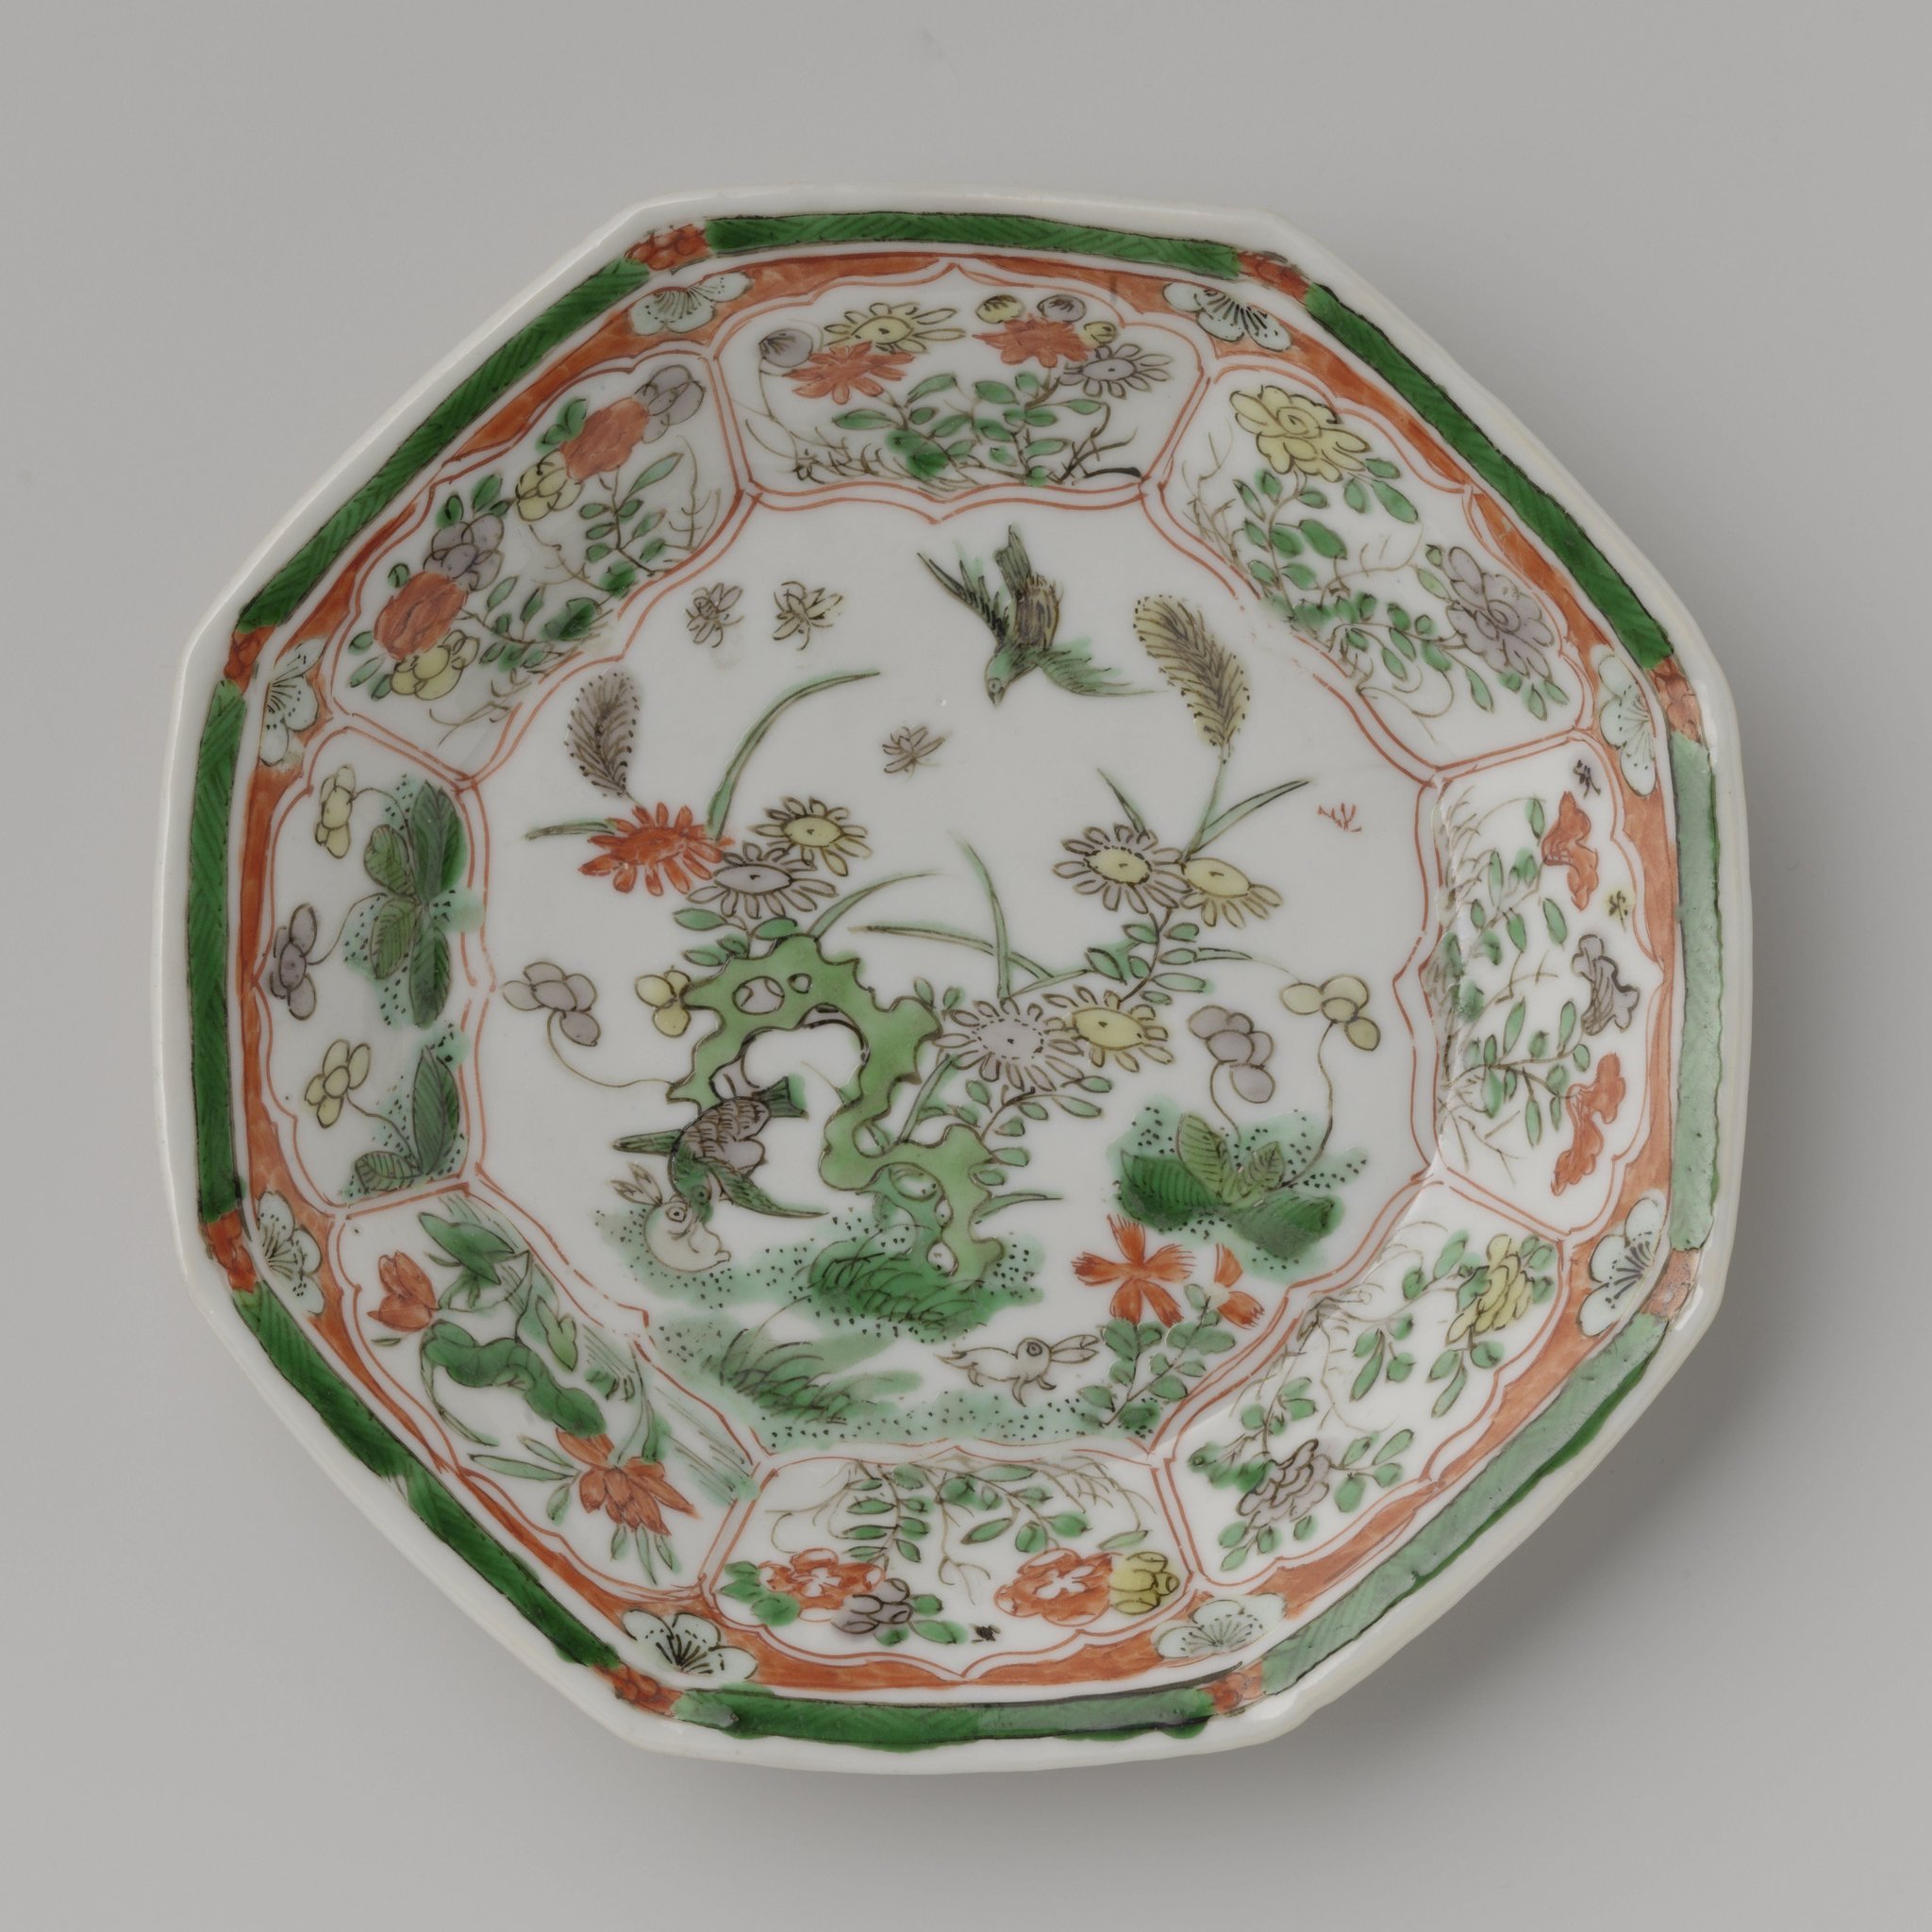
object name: platter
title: Octagonal saucer with light brown, animals and flower sprays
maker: Anonymous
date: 1700-1724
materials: cobalt, glaze, paint, porcelain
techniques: firing, forming, turning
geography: china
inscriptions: mark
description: Kop en schotel, achtkantig, cafe-au-lait, famille verte, met decors van bloeiende planten, haasjes en vogels. Op de buitenzijde zijn op een zeemleerkleurig fond bloempjes in afstekende kleuren aangebracht.